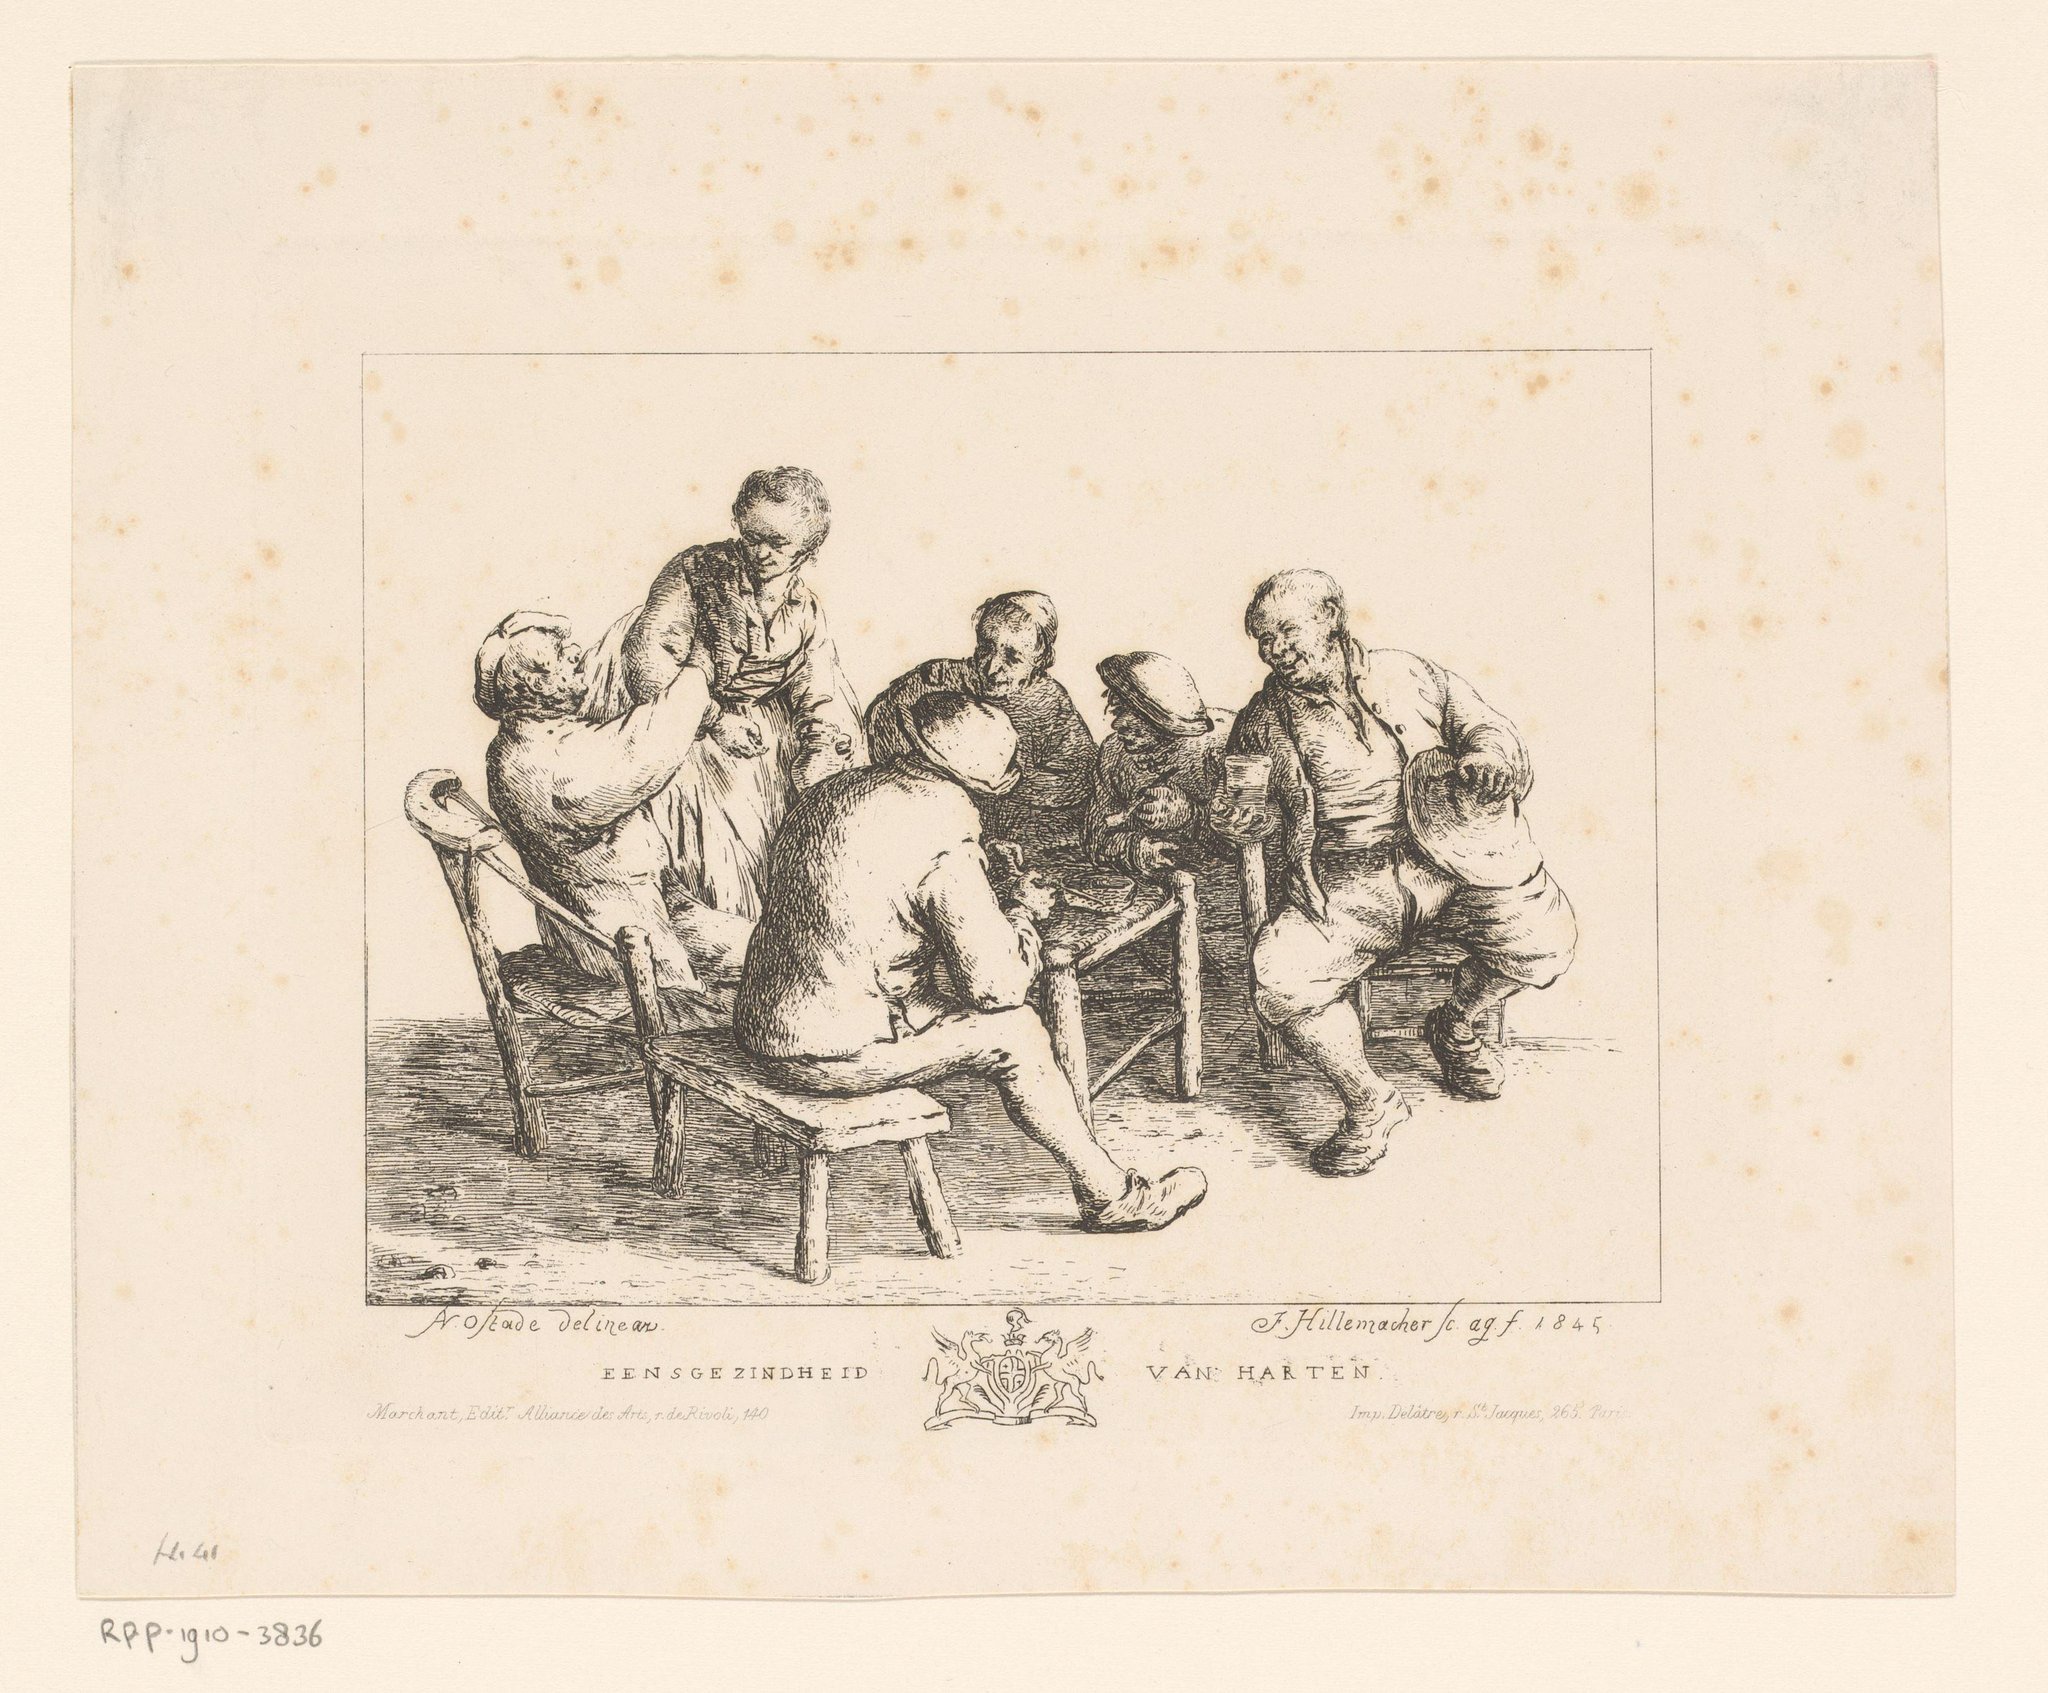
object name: print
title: Drinkende boeren rondom een tafel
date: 1845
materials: paper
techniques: etching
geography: paris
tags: pipe ~ tobacco, drinking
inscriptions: collector's mark: Lugt 2228